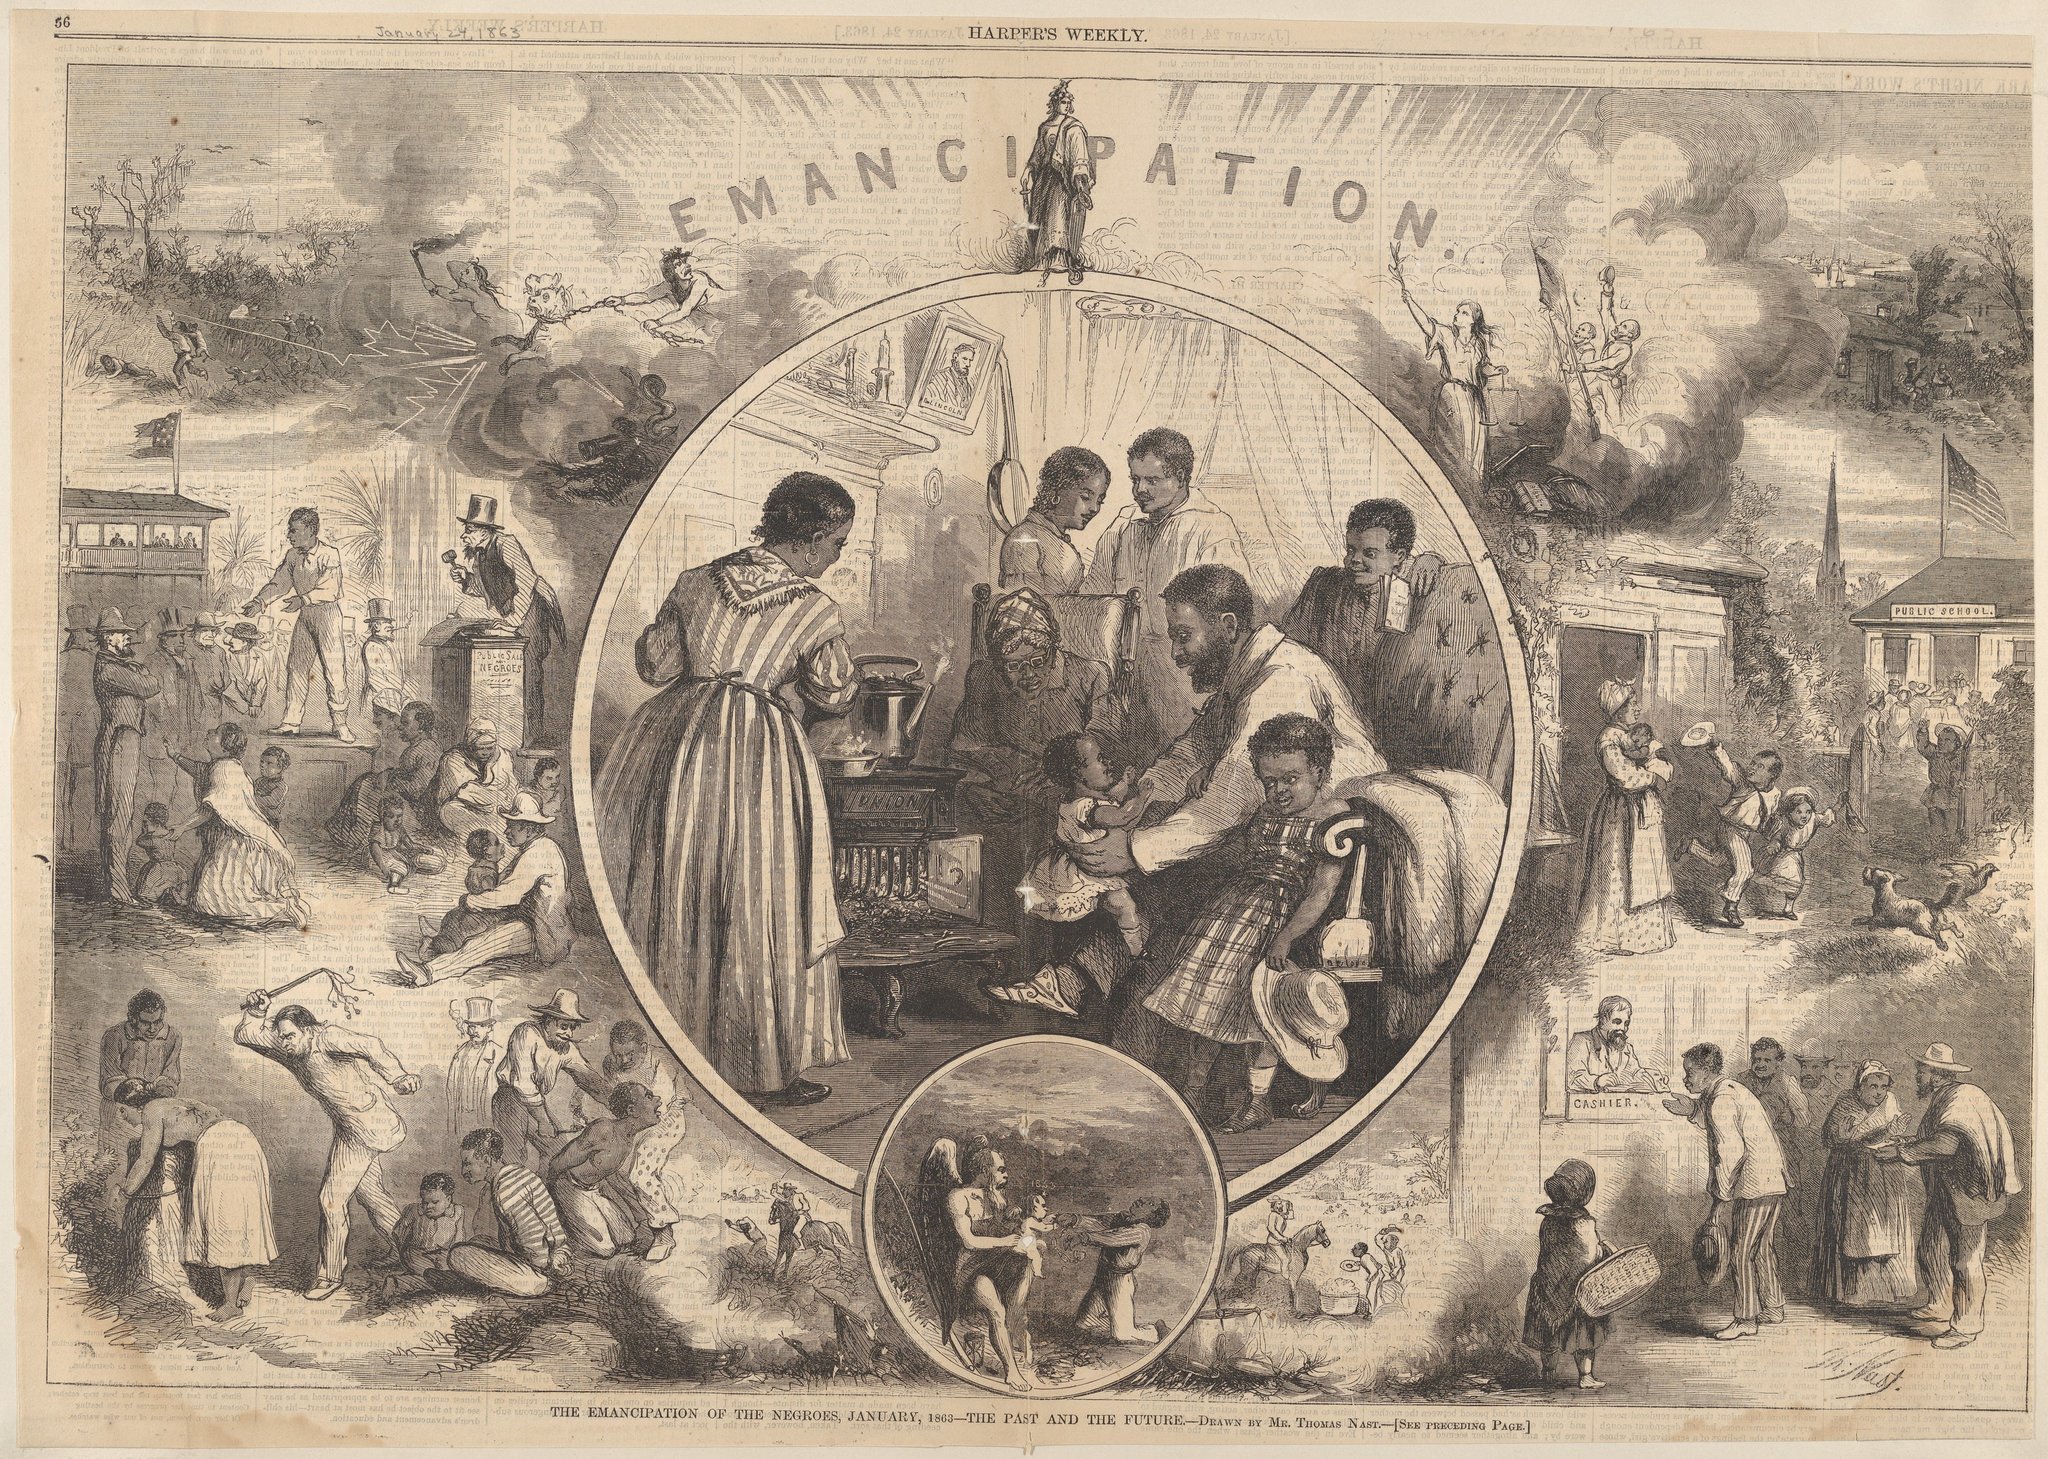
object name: print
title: Emancipation of the Negroes – The Past and the Future (from "Harper's Weekly")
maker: thomas nast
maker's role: artist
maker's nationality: american, born germany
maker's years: 1840-1902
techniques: engraving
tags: american civil war,girls,men,women,slavery